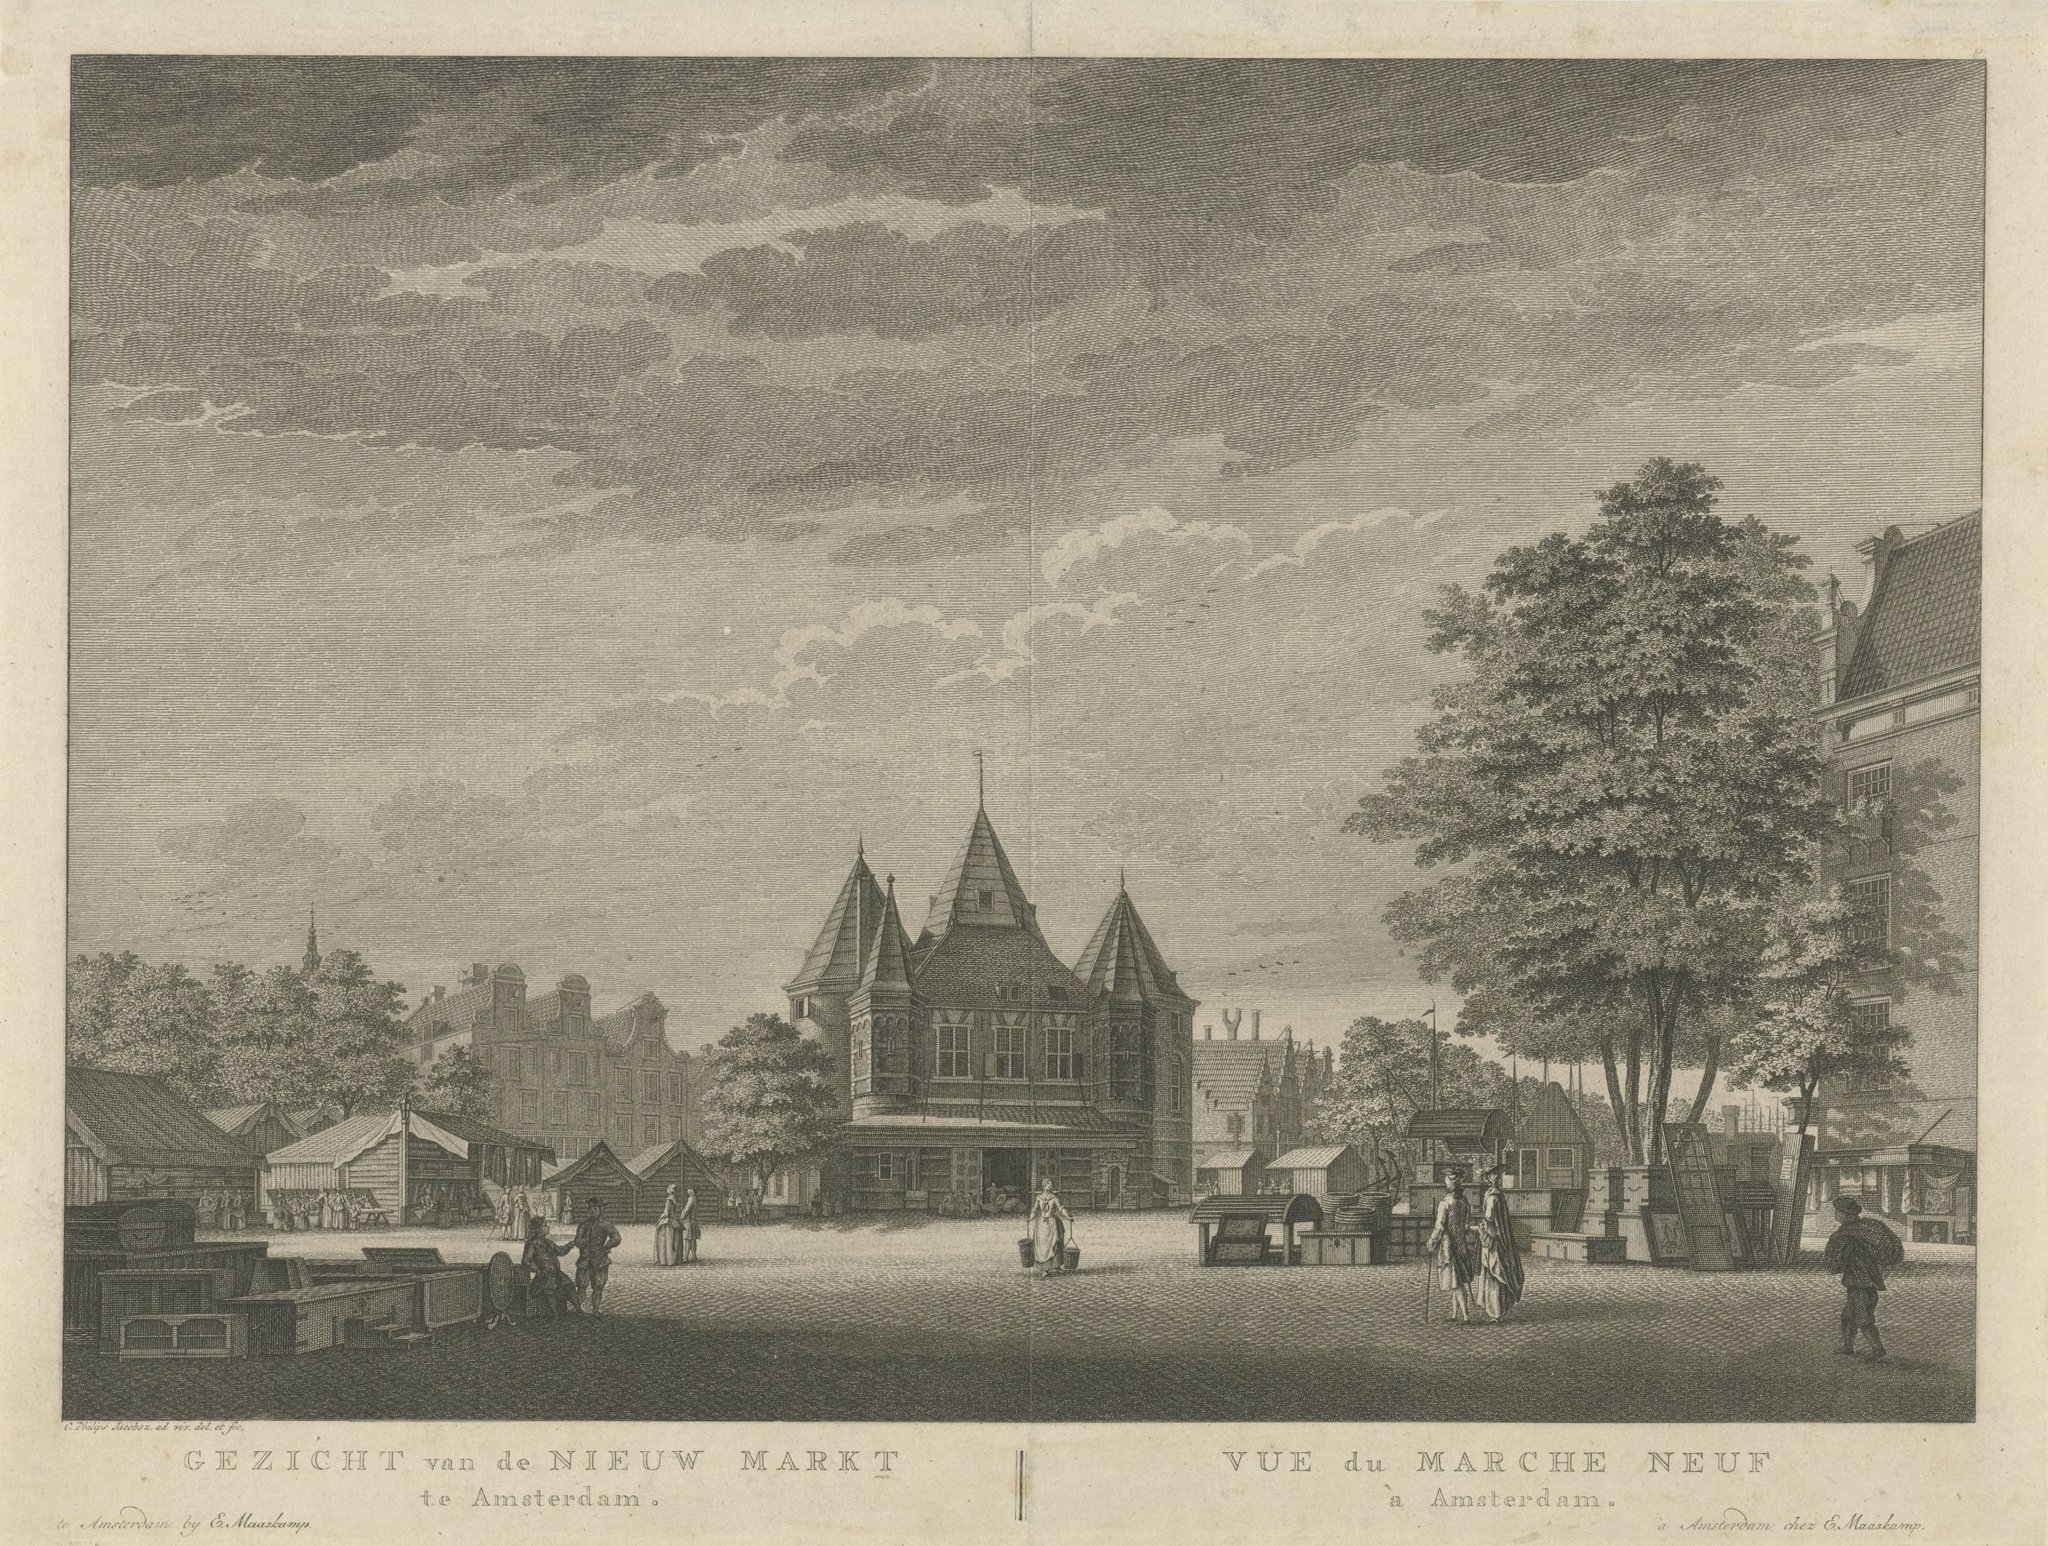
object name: print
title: Gezicht op de Nieuwmarkt te Amsterdam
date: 1767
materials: paper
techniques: engraving, etching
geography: amsterdam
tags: stall, booth (~ market), market, weigh-house, square, place, circus, etc. (+ city(-scape) with figures, staffage)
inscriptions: collector's mark: Lugt 2228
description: Deze prent is ook gebruikt in de zogenaamde Atlas van Fouquet.* Pierre Fouquet gaf vanaf 1760 stadsgezichten van Amsterdam - naar tekeningen van verschillende kunstenaars, gemaakt door verschillende prentmakers - uit. Deze prenten werden aanvankelijk los of in series verkocht. Zoals toen gebruikelijk kon de koper de prenten zelf laten inbinden. Hiertoe gaf Fouquet tussen 1778 en 1783 een titelblad, plattegrond en inhoudsopgave van de tot dusver 100 uitgegeven prenten uit (1). Gezien de inhoud afhankelijk was van wat de koper had verzameld verschilt de inhoud van de verschillende bewaarde Fouquetatlassen onder deze titel sterk. Ook zijn er exemplaren bekend waar tevens andere prenten aan zijn toegevoegd. Omdat er behoefte bleek aan uitleg bij de platen werd in 1783 een nieuwe versie van de atlas uitgegeven, aangevuld met tekst en twee prenten. De aangegeven volgorde veranderde maar de platen van de al eerder uitgegeven prenten bleven ongewijzigd. Deze uitgave werd in opdracht van Fouquet gedrukt bij Daniël Jean Changuion en Petrus den Hengst (2). Een tiental platen werd bijgewerkt en verscheen, met nieuw impressum, in het vervolg van Wagenaars geschiedenis van Amsterdam, uitgeven door Petrus Conradi en Folkert van der Plaats (3). Een aantal jaar na het overlijden van Fouquet kwam Evert Maaskamp met een nieuwe uitgave van de atlas, met verbeterde tekst en toevoeging van twee prenten. Op alle platen verwijderde hij het oude en liet hij zijn eigen impressum zetten (4). De huidige staat van de prent komt voor in de onder (4) genoemde publicatie. * Onder de Atlas van Fouquet of Fouquetatlas verstaan we de hieronder vermelde publicaties (1), (2) en (4). (1). Afbeeldingen van de wyd-vermaarde koopstad Amsterdam benevens des zelvs voornaamste gebouwen en gezigten alle naar het leeven getekend / Receuil des edifices les plus considerables et des plus belles vues, de la fameuse ville d'Amsterdam, dessinées d'après nature. Amsterdam: Pierre Fouquet, 1778-1783. (2). Nieuwe atlas, van de voornaamste gebouwen en gezigten der stad Amsterdam, met derzelver beknopte beschryvingen. 2 delen. Amsterdam: Daniël Jean Changuion en Petrus den Hengst [in opdracht van Pierre Fouquet], 1783. (3). Stijl, Simon. Amsterdam, in zyne geschiedenissen, voorregten, koophandel, gebouwen, kerkenstaat, schoolen, schutterye, gilden en regeeringe, beschreeven. Om te dienen ten vervolge op het werk van Jan Wagenaar (…). 10 delen. Amsterdam en Harlingen: Petrus Conradi en Folkert van der Plaats, 1788-1801. (4). Nieuwe atlas, van de voornaamste gebouwen en gezigten der stad Amsterdam. Met derzelver beknopte beschryvingen. Amsterdam: Evert Maaskamp, 1805. * Het aantal vermelde staten is gebaseerd op het aantal gevonden staten. Mogelijk zijn er meer staten van deze prent. Voor eerste of tweede bekende staat zie RP-P-OB-60.125.